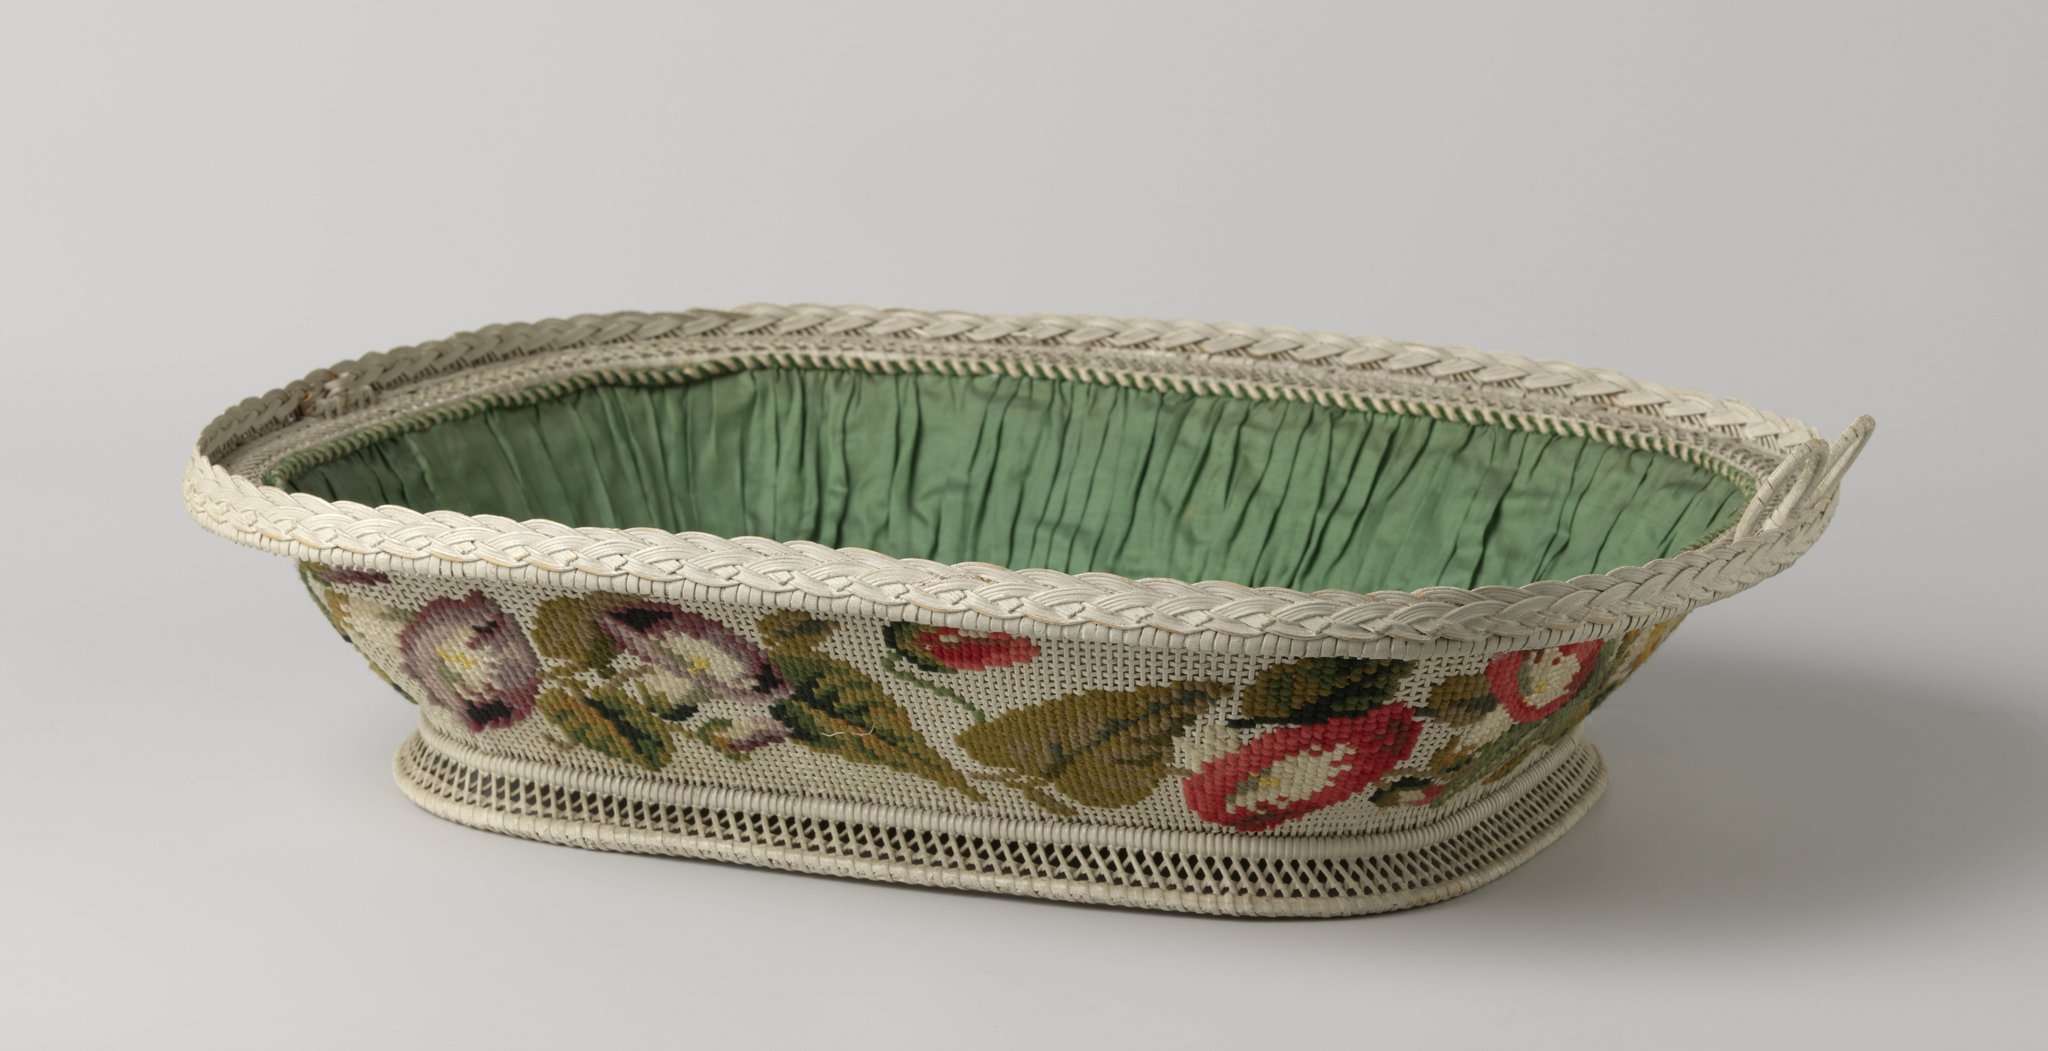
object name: luiermand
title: Witte luiermand versierd met Berlijns kruissteekborduurwerk in wol; groene voering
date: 1840-1860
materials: paint, wool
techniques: embroidery, cross stitching, embroidered